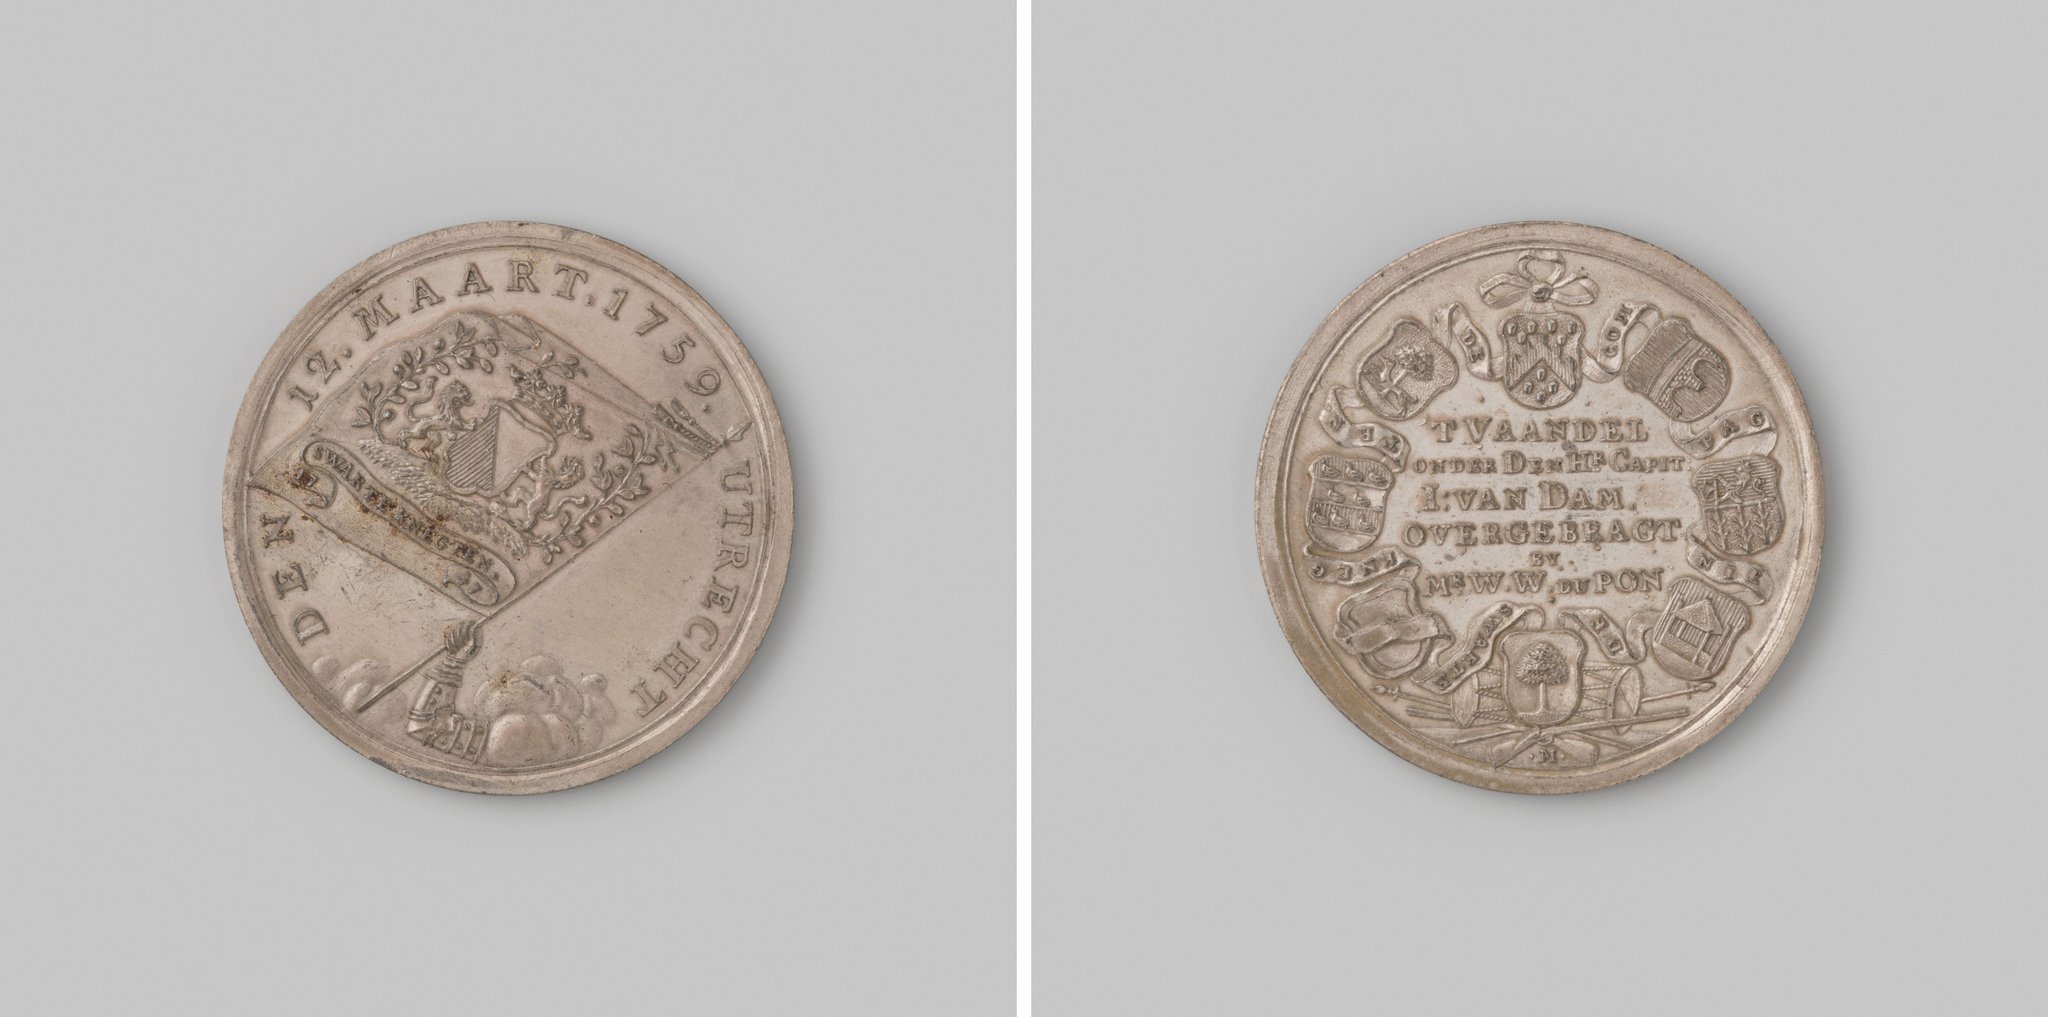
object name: history medal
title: Op het overbrengen van het vaandel der Compagnie de Swarte Knegten te Utrecht onder bevel van kapitein J. Van Dam naar Mr. W.W. du Pon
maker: johann conrad marmé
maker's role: die cutter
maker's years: 1710-1772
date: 1759-1779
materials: silver